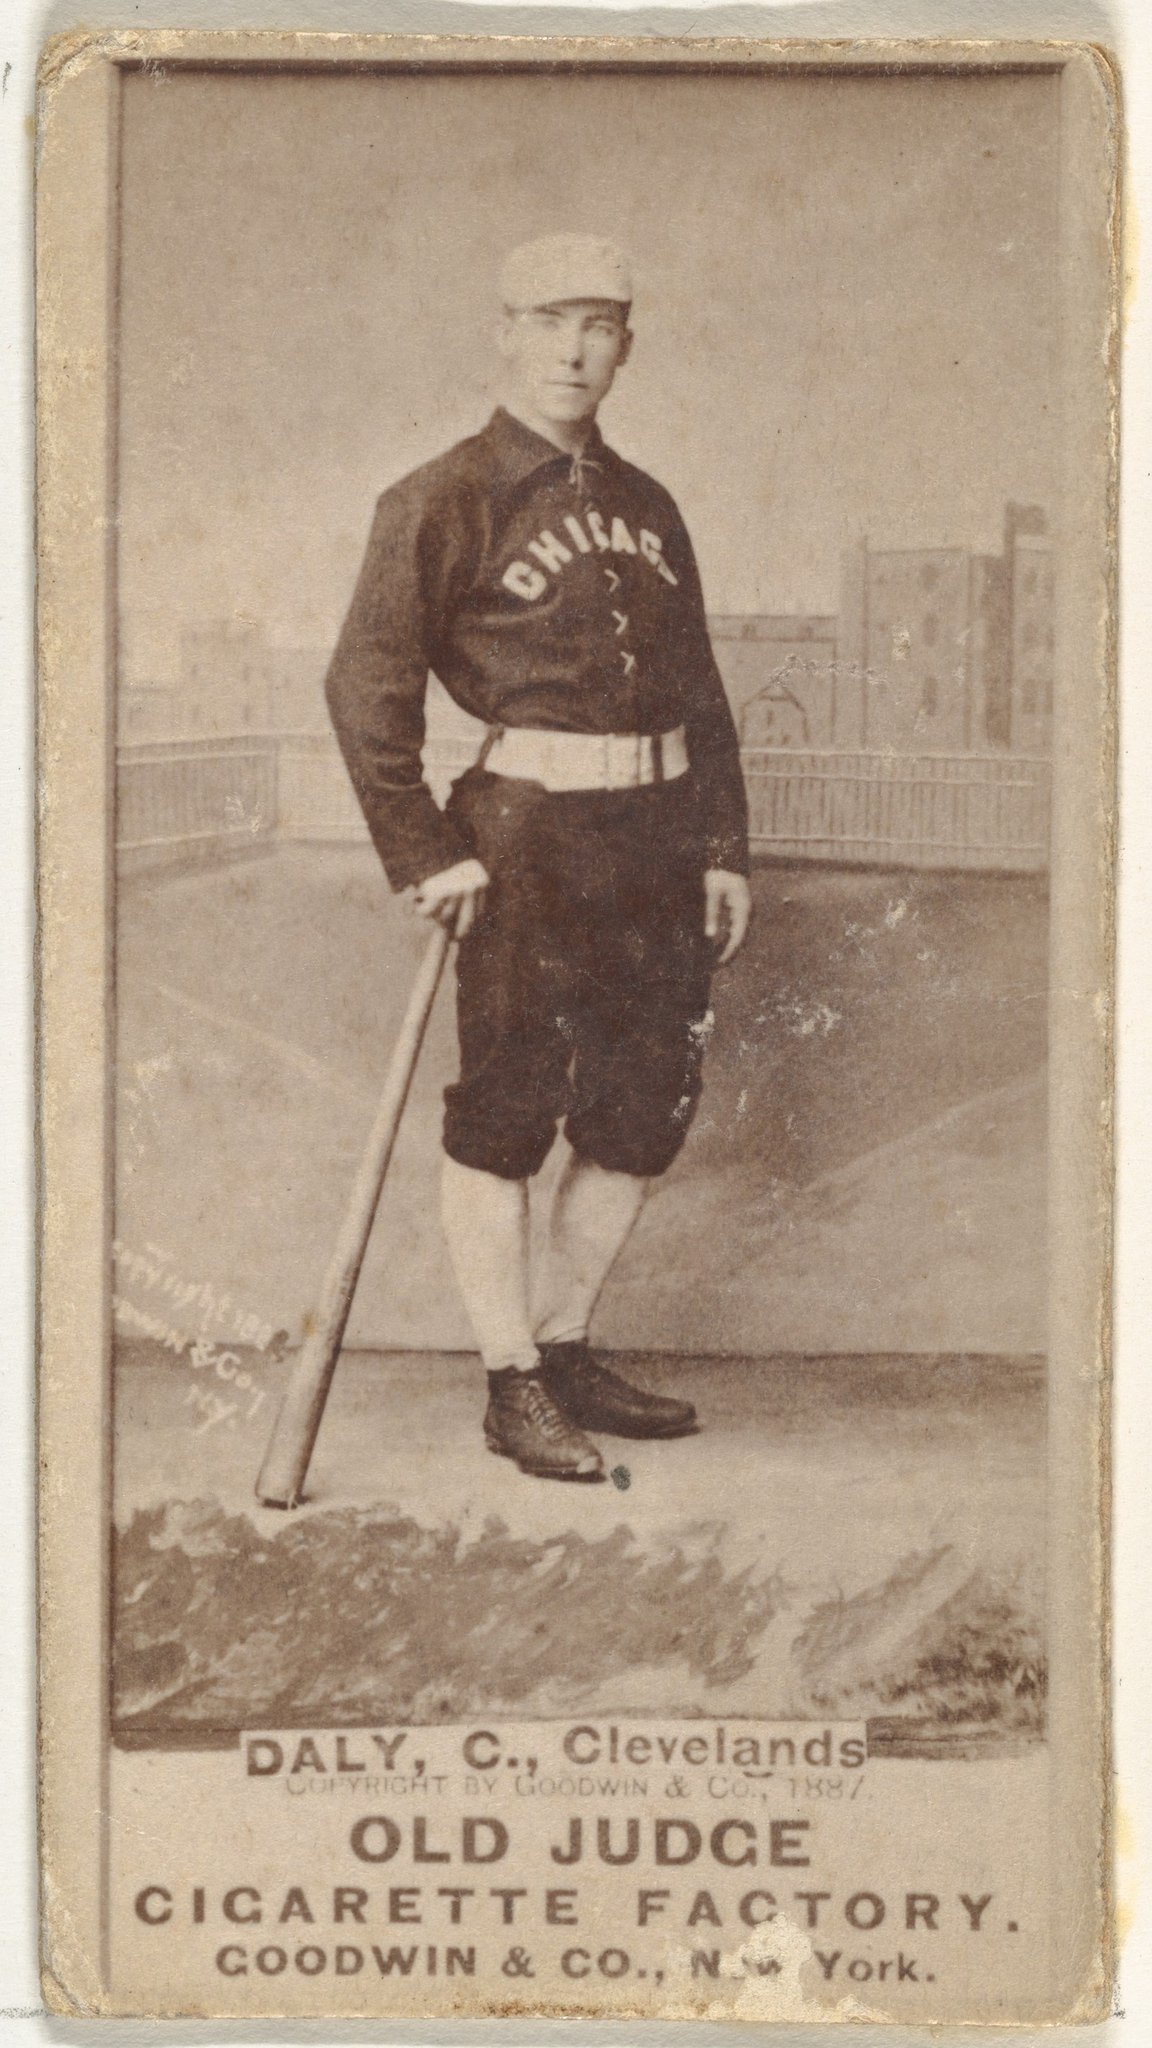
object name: baseball card, photograph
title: Hugh Ignatius Daily, Catcher, Cleveland, from the Old Judge series (N172) for Old Judge Cigarettes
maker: goodwin & company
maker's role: publisher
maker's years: 1850-1950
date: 1887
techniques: albumen silver print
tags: men,portraits,baseball,athletes